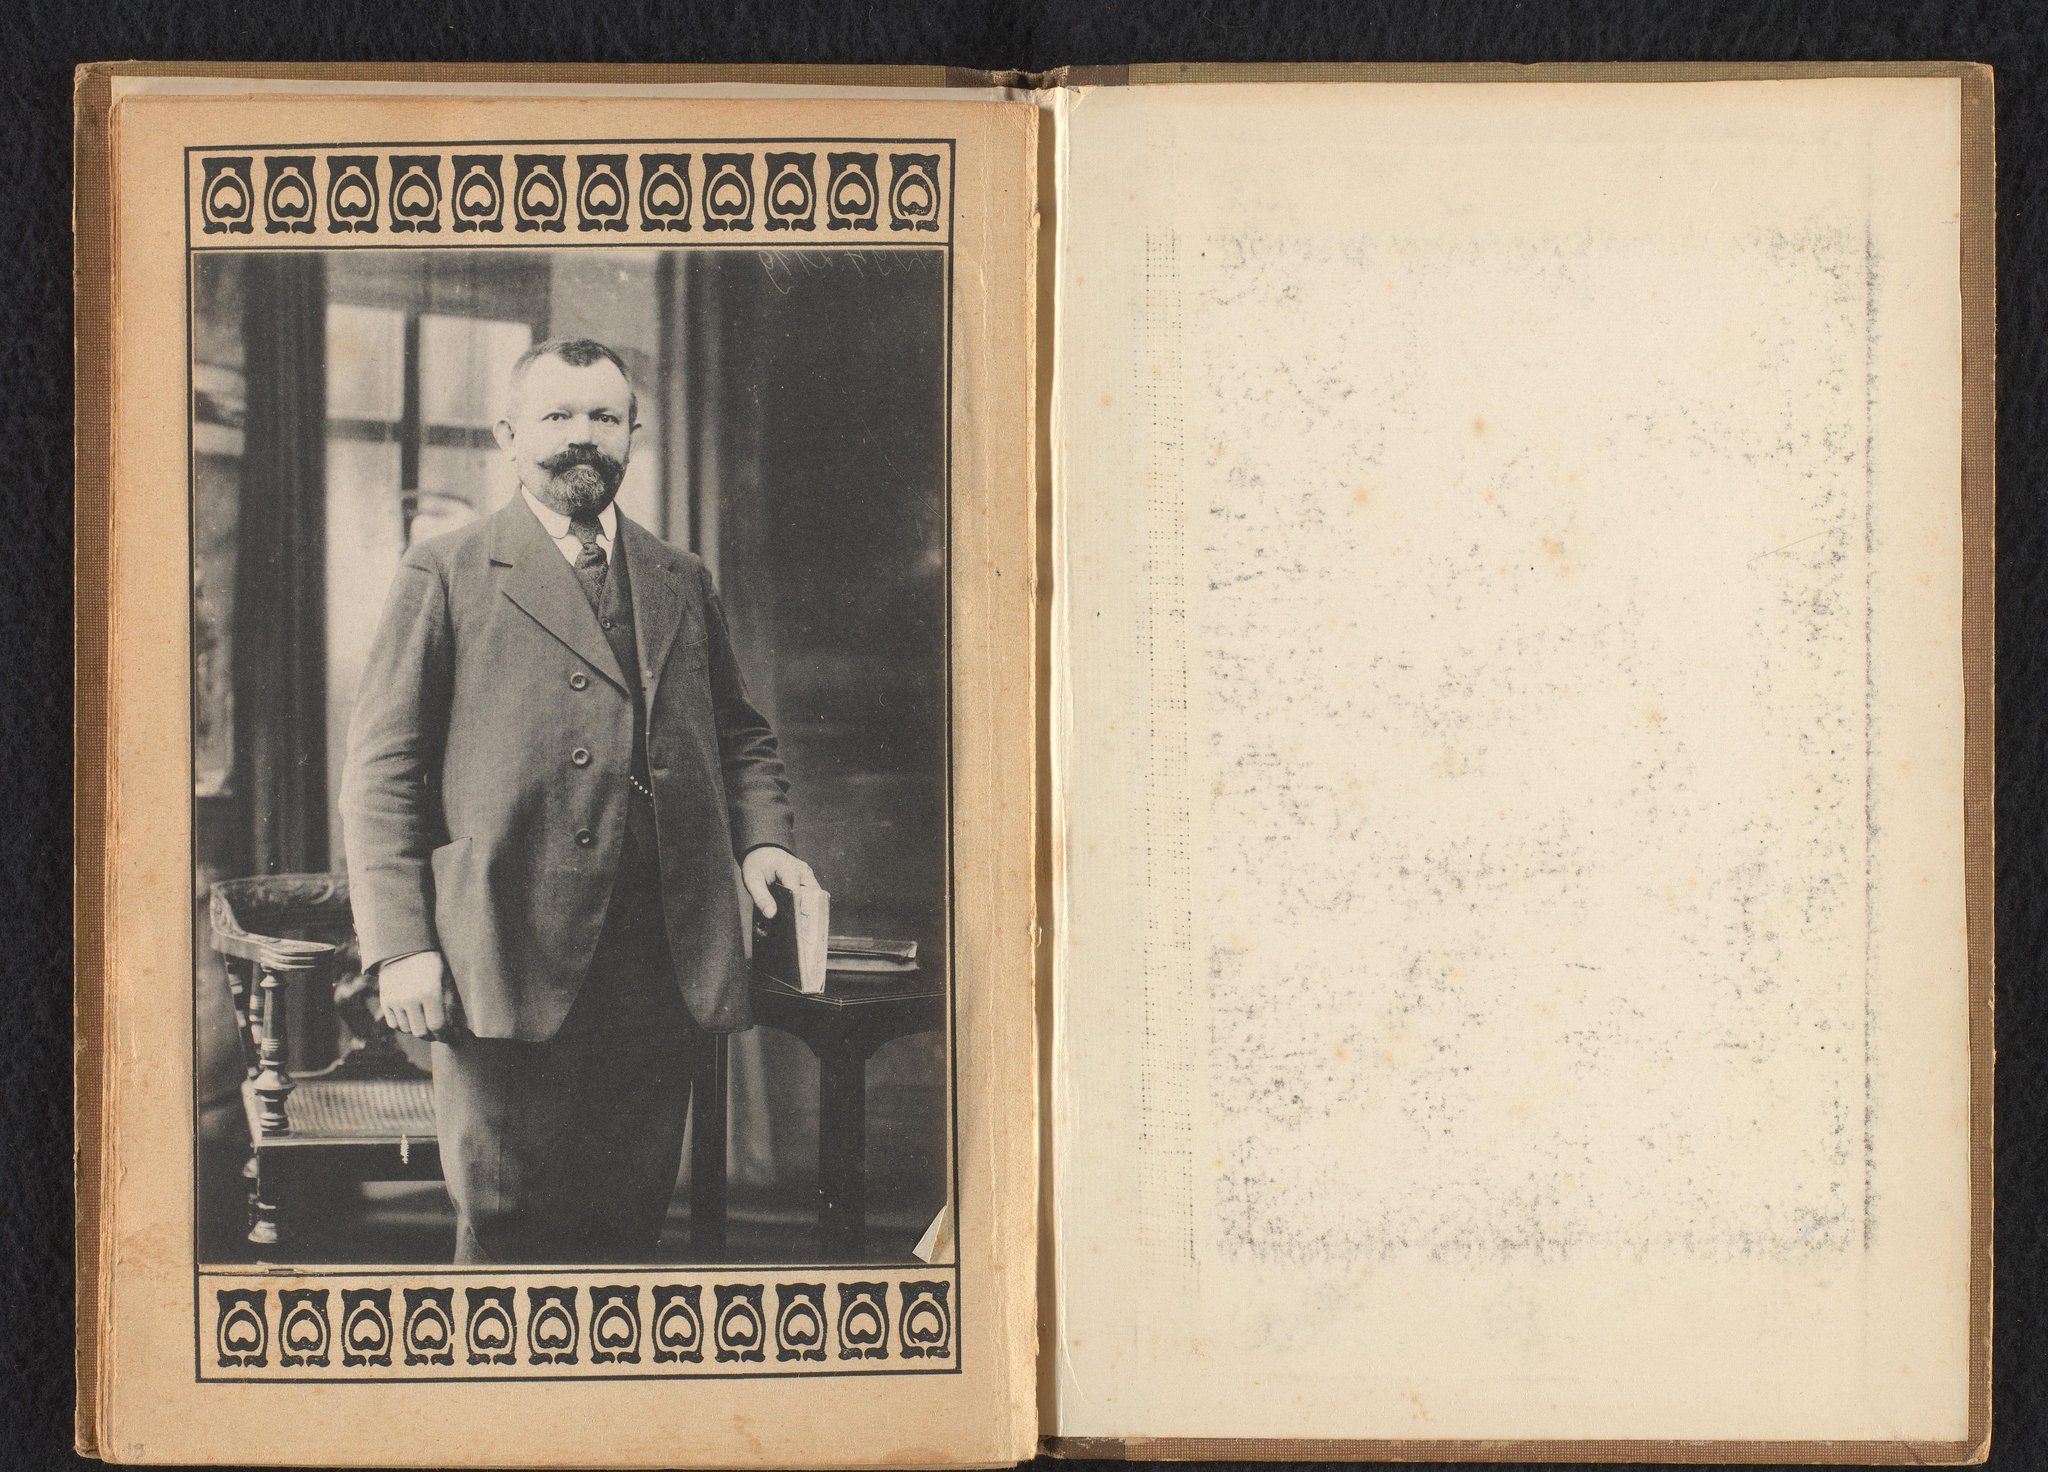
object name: page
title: E.R. Kietz, directeur van de Biscuit-, Chocolade- und Zuckerwaaren-Fabrikation te Langensalza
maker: Anonymous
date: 1900-1905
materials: paper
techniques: photograph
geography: bad langensalza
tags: e.r. kietz, historical persons - bb - woman, director, boss (in modern industry), book - mm - book open, biscuits